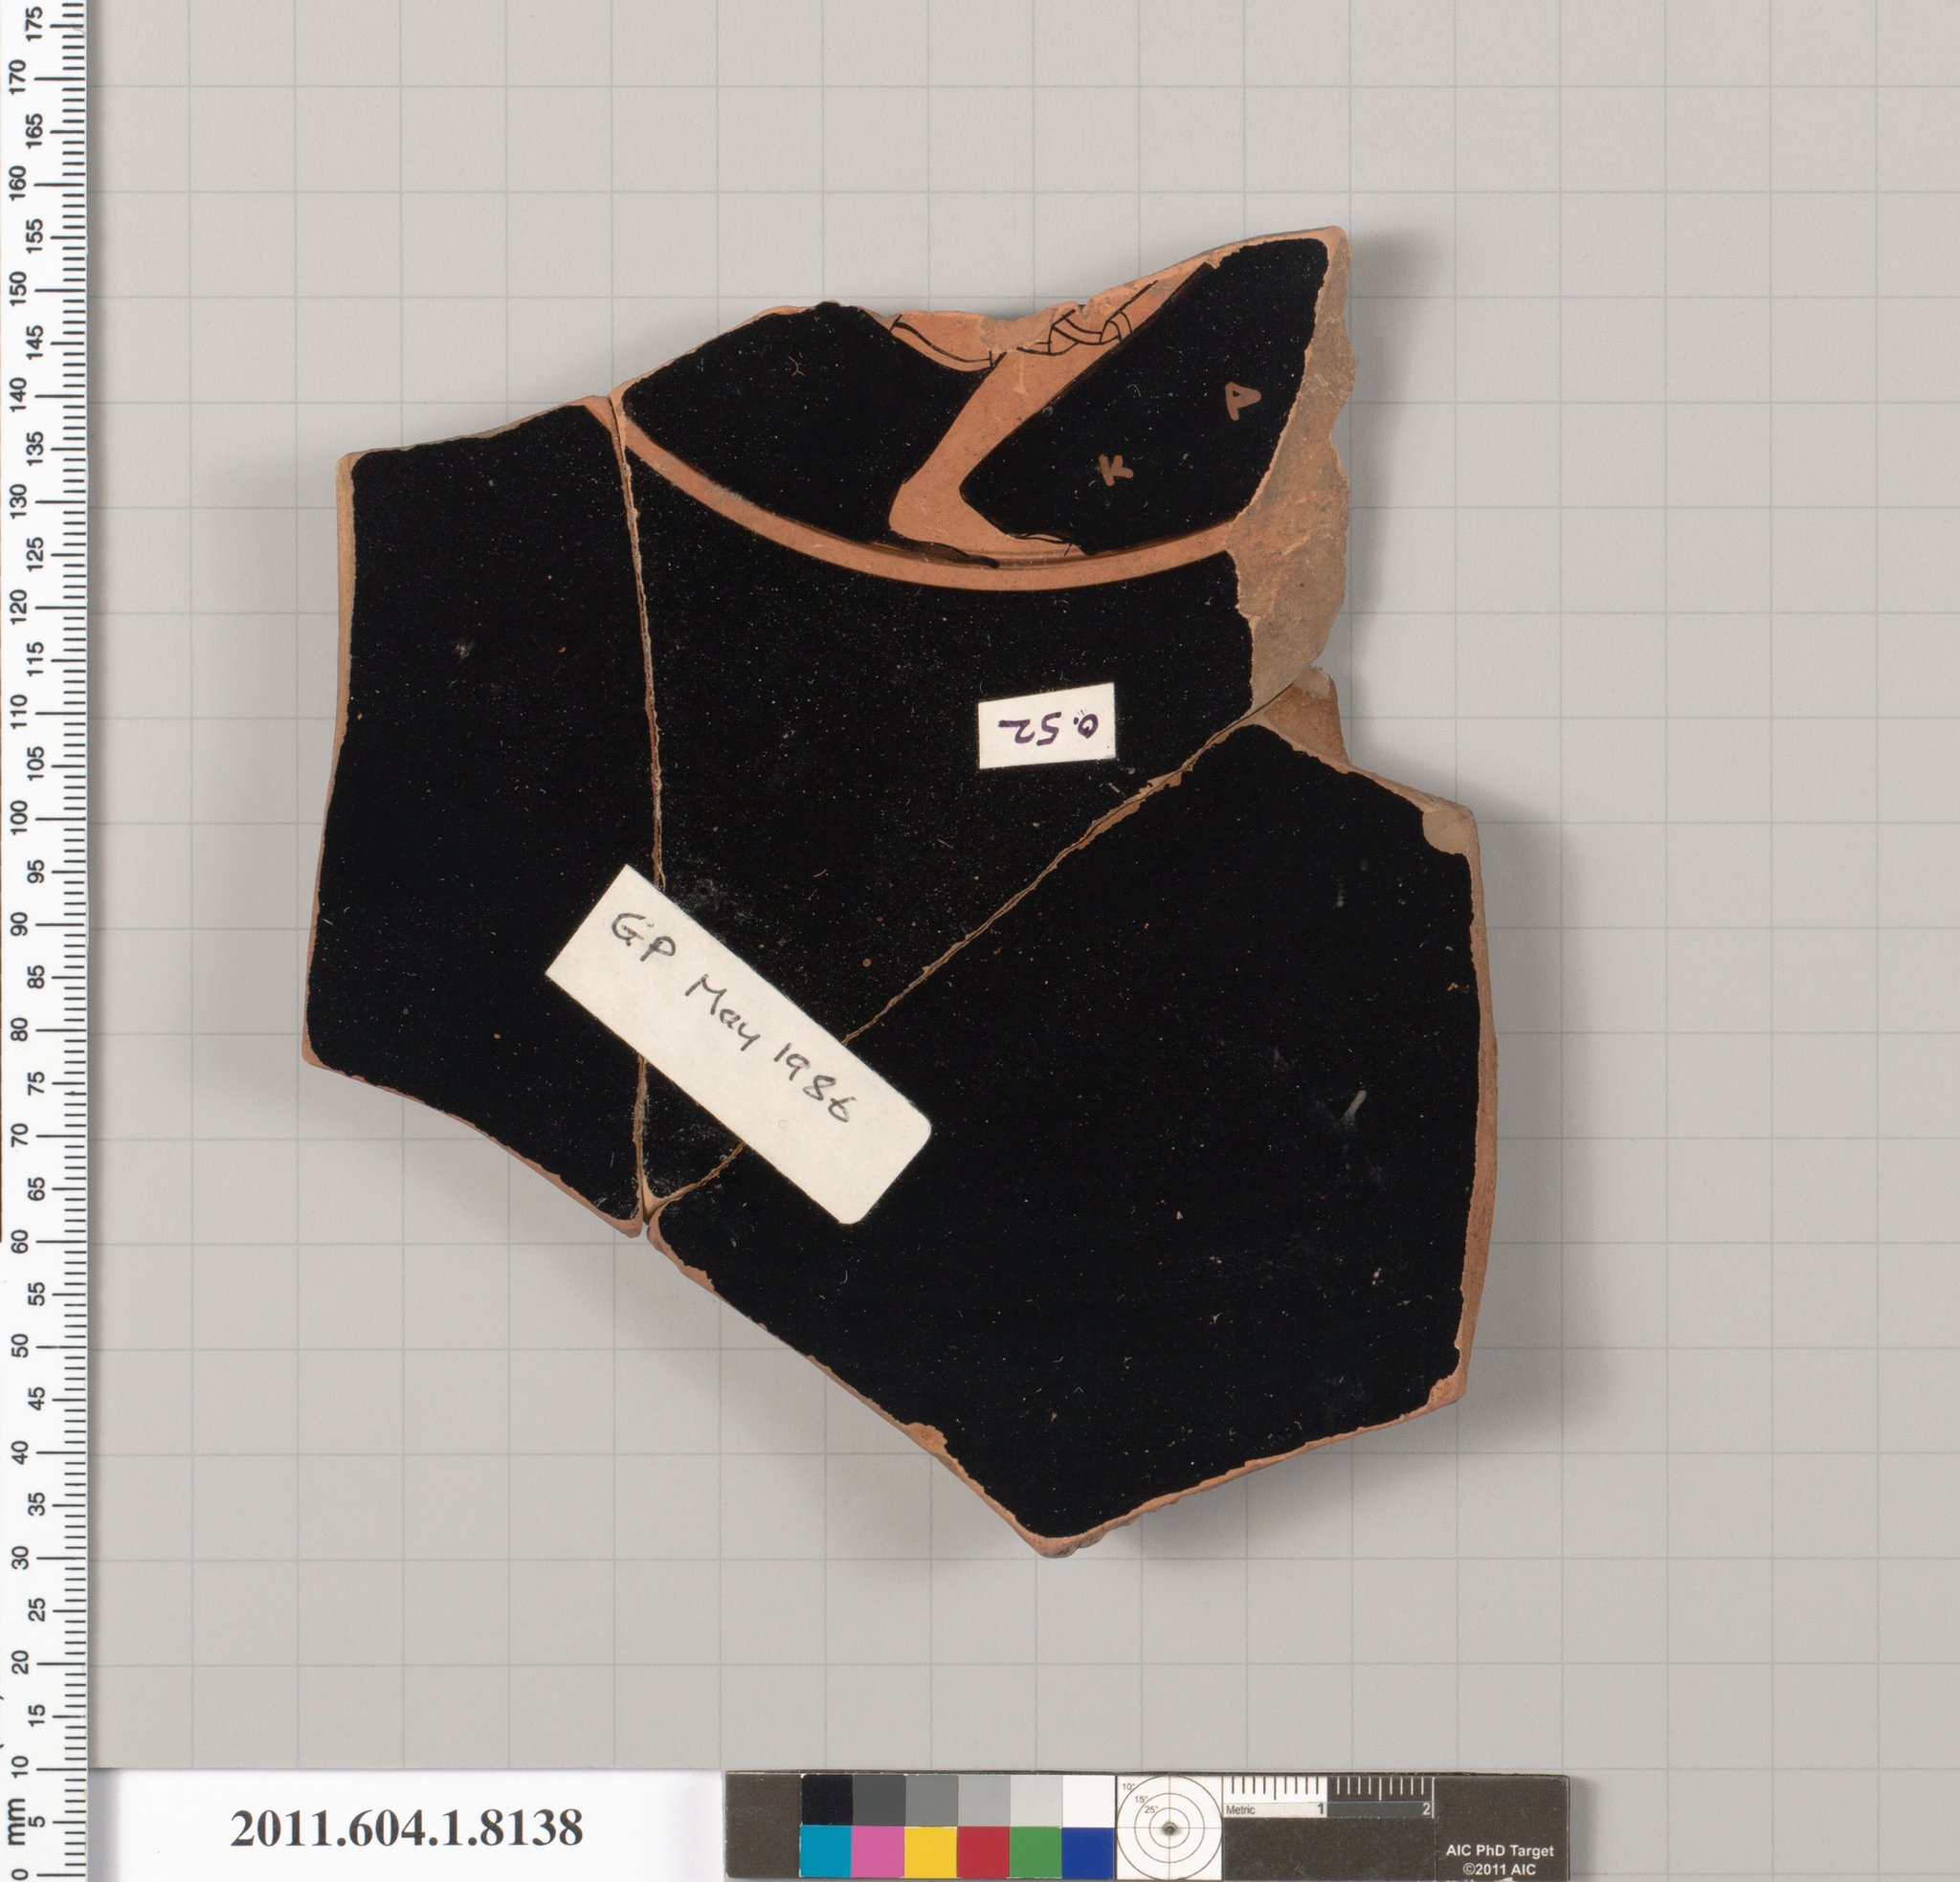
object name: kylix fragment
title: Terracotta fragment of a kylix (drinking cup)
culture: greek, attic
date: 520-500 BCE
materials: terracotta